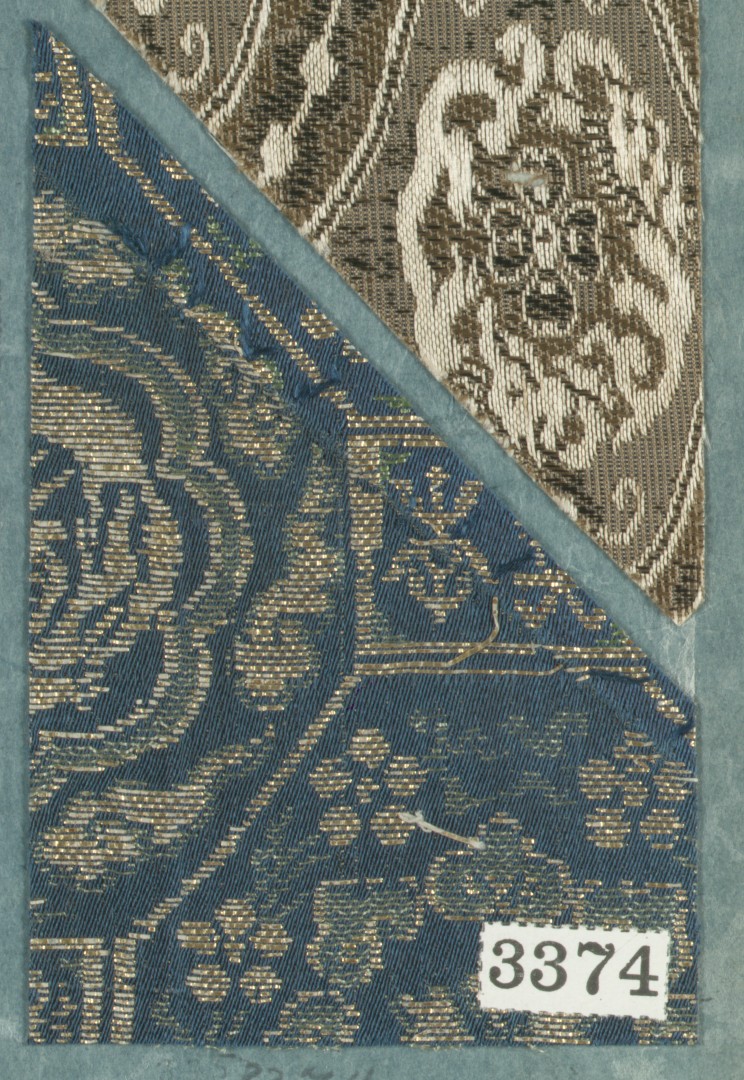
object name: textile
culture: japanese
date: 1801-1900